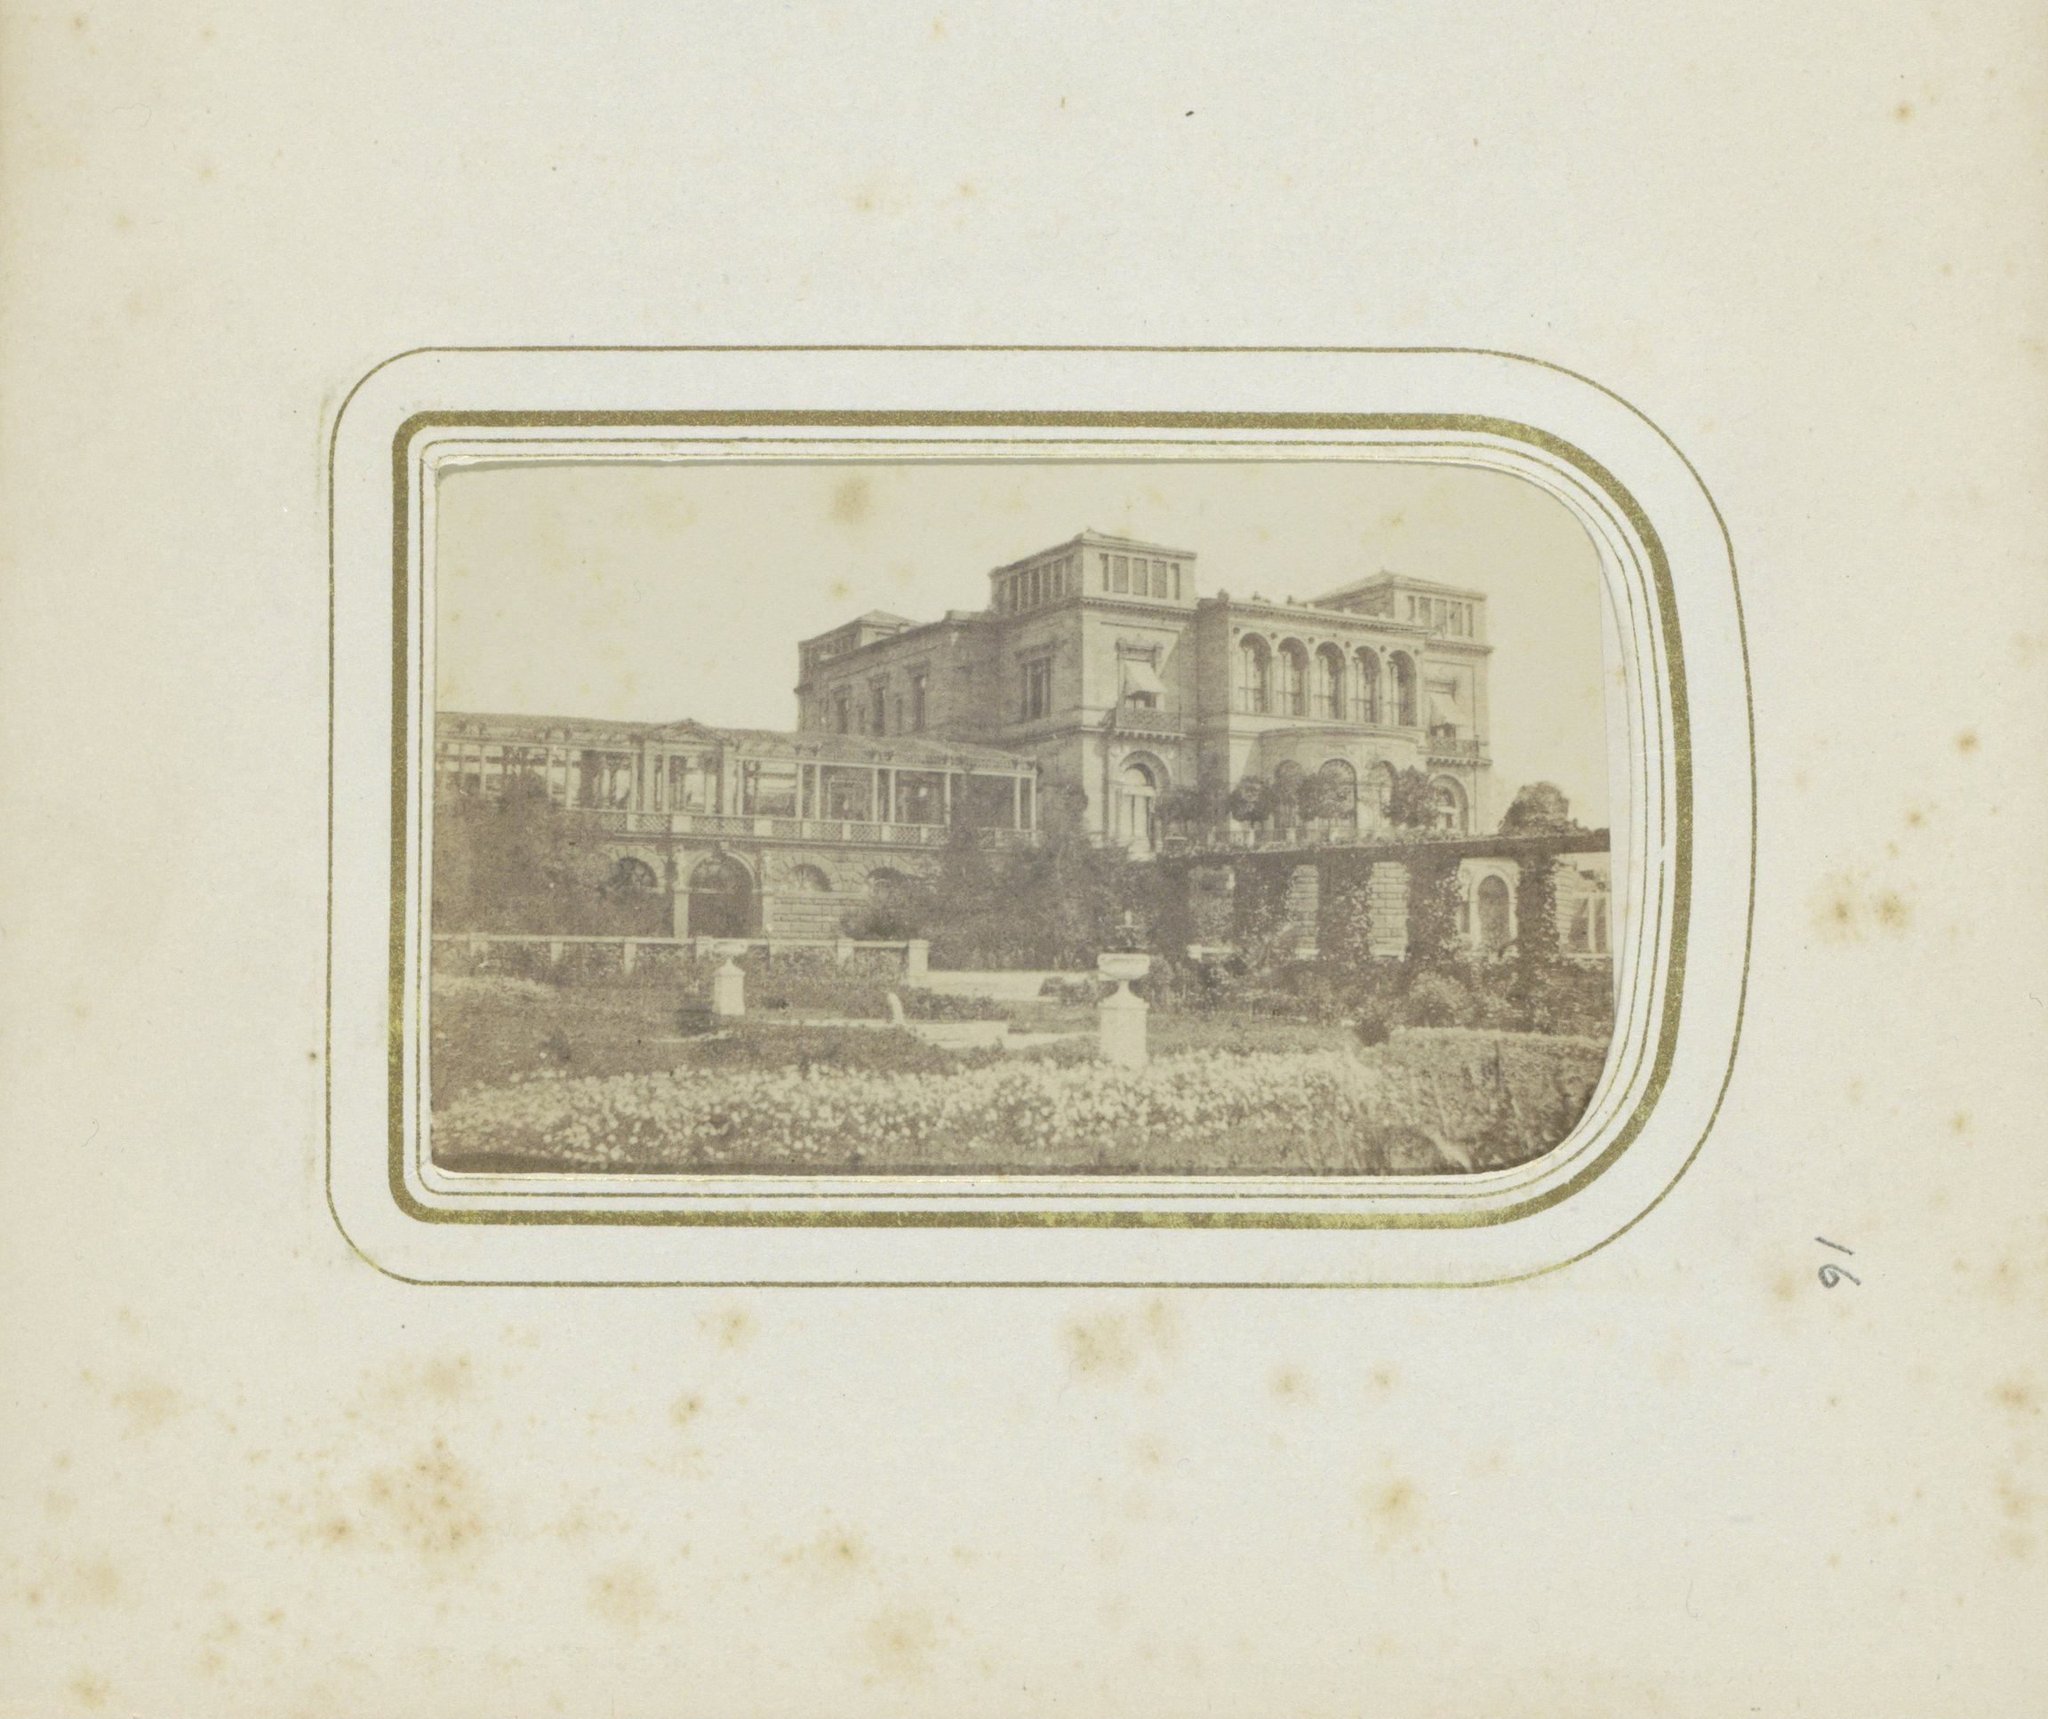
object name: photograph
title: Exterieur van Villa Berg (Koningsvilla) in Stuttgart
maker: Anonymous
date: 1865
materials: paper, photographic support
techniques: albumen print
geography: stuttgart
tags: castle, garden, travelling; tourism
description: Onderdeel van Fotoalbum van een reis door Zwitserland, Oostenrijk en Duitsland door de Nederlandse familie Derkinderen.